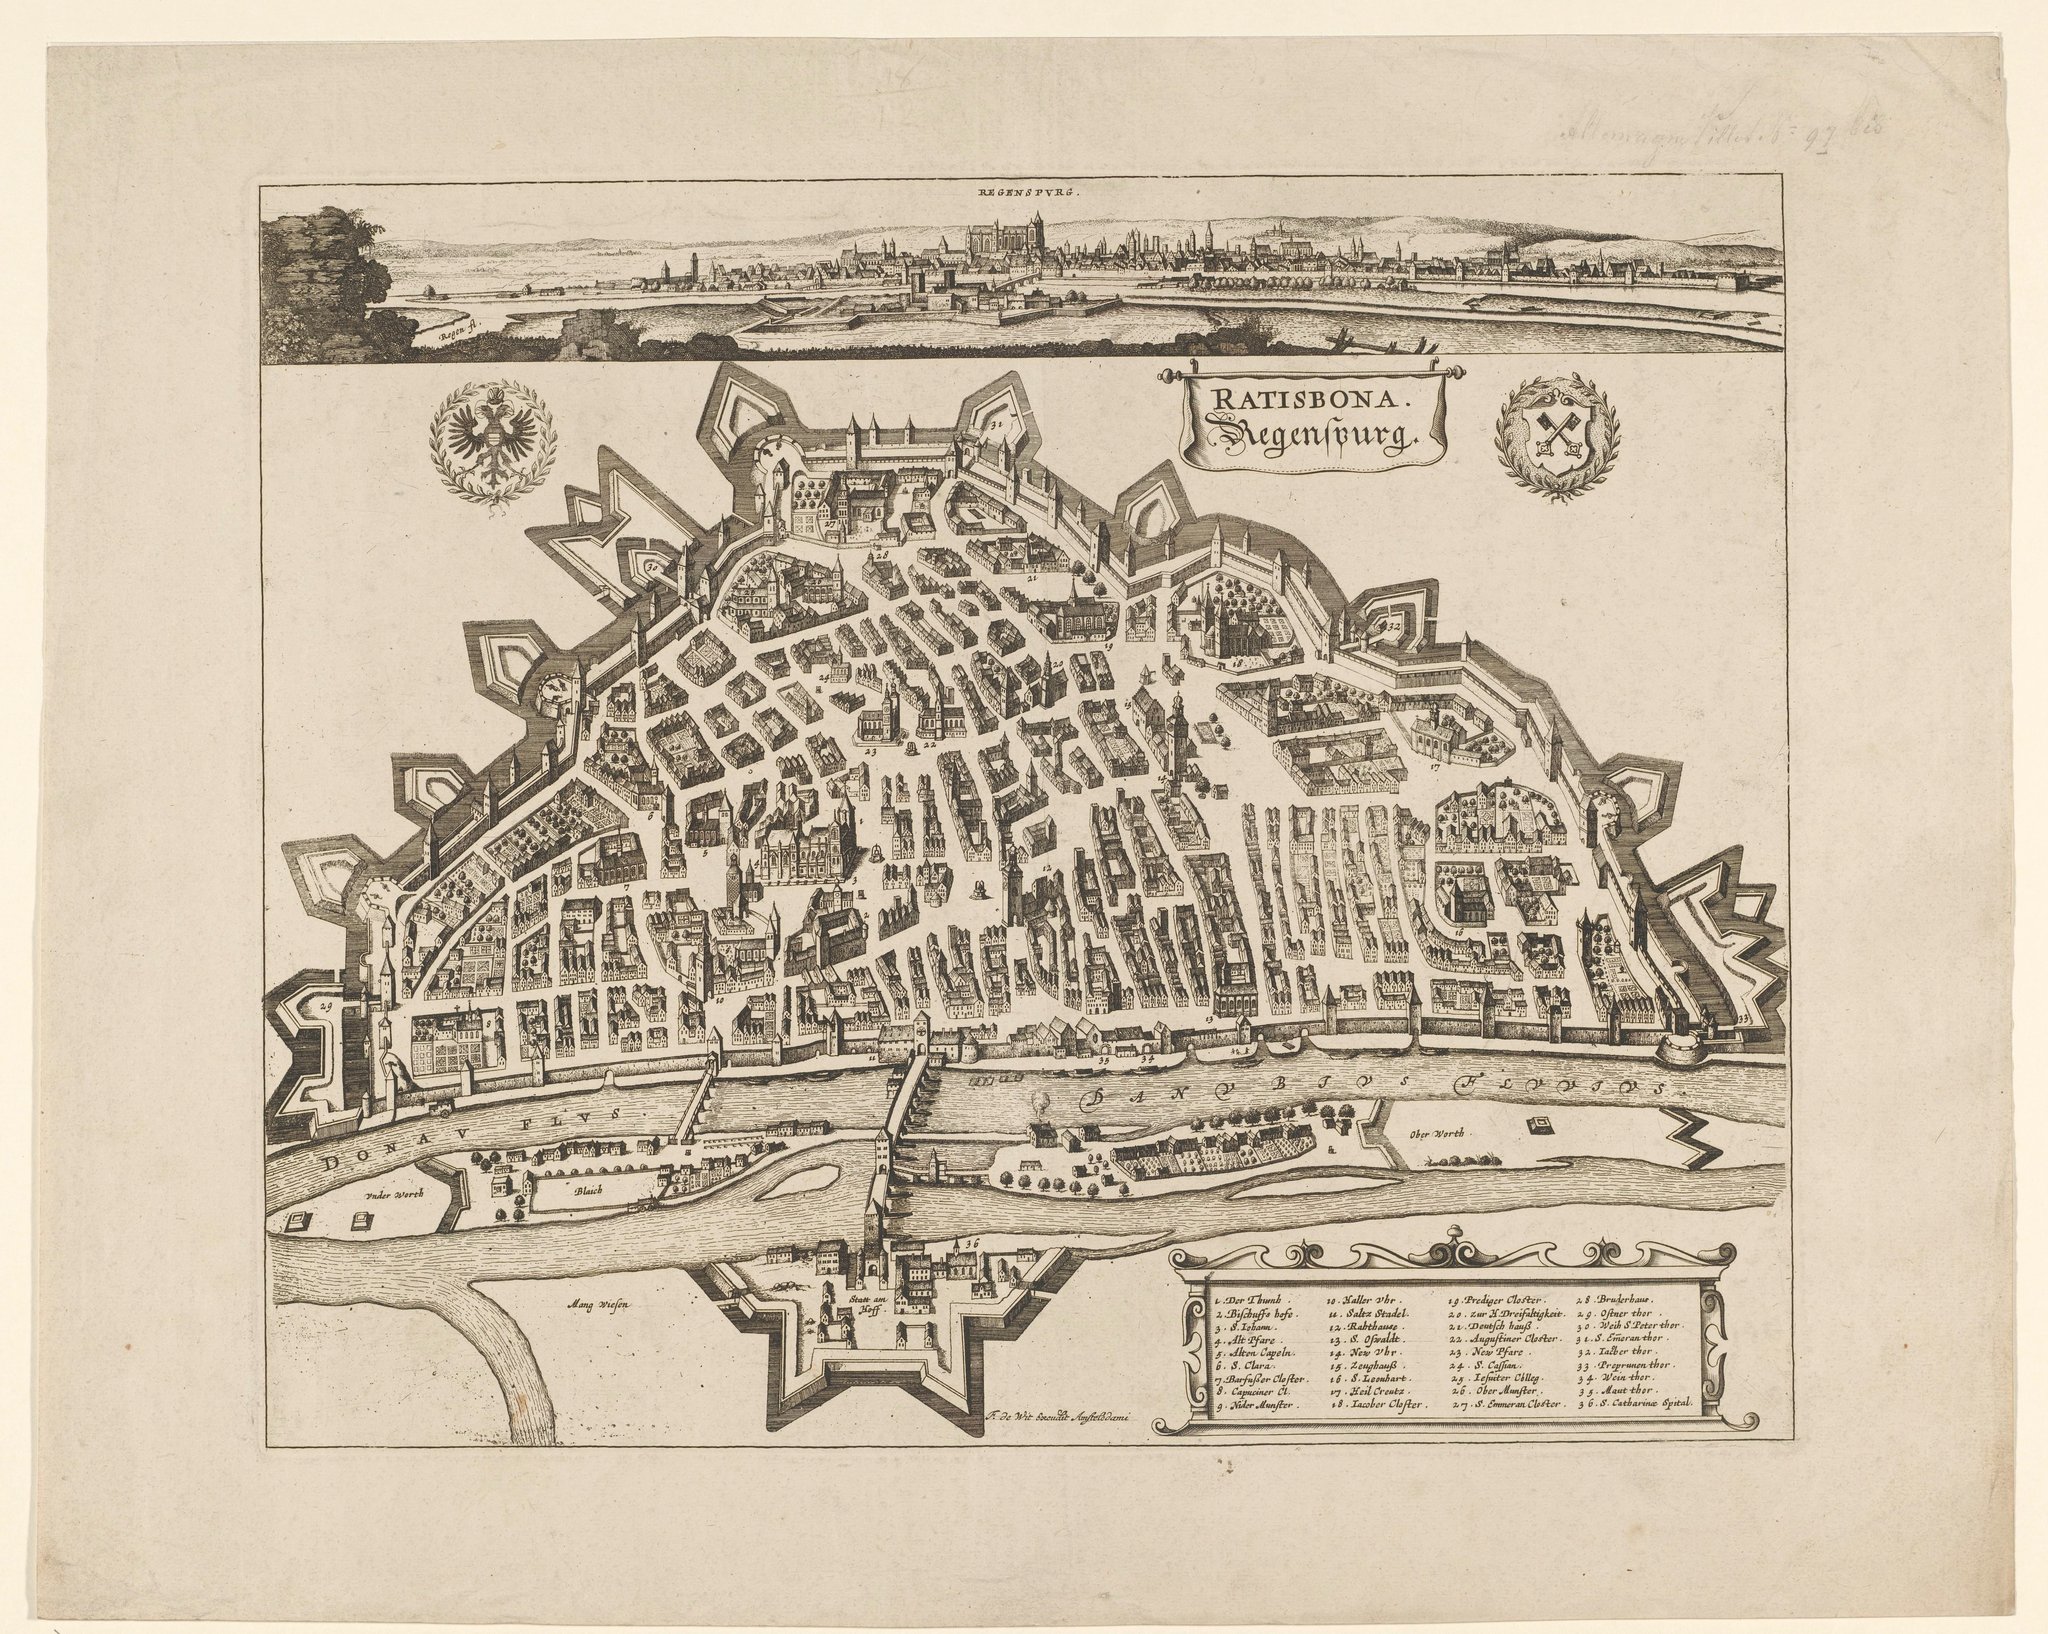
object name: print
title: Plattegrond van en gezicht op Regensburg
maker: Anonymous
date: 1695-1728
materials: paper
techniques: engraving, etching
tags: coat of arms (as symbol of the state, etc.) (+ city; municipal), maps of cities, coat of arms (as symbol of the state, etc.) (+ province; provincial), prospect of city, town panorama, silhouette of city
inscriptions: collector's mark: Lugt 2228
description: Linksboven het wapen van het Heilige Roomse Rijk, rechtsboven het wapen van Regensburg.